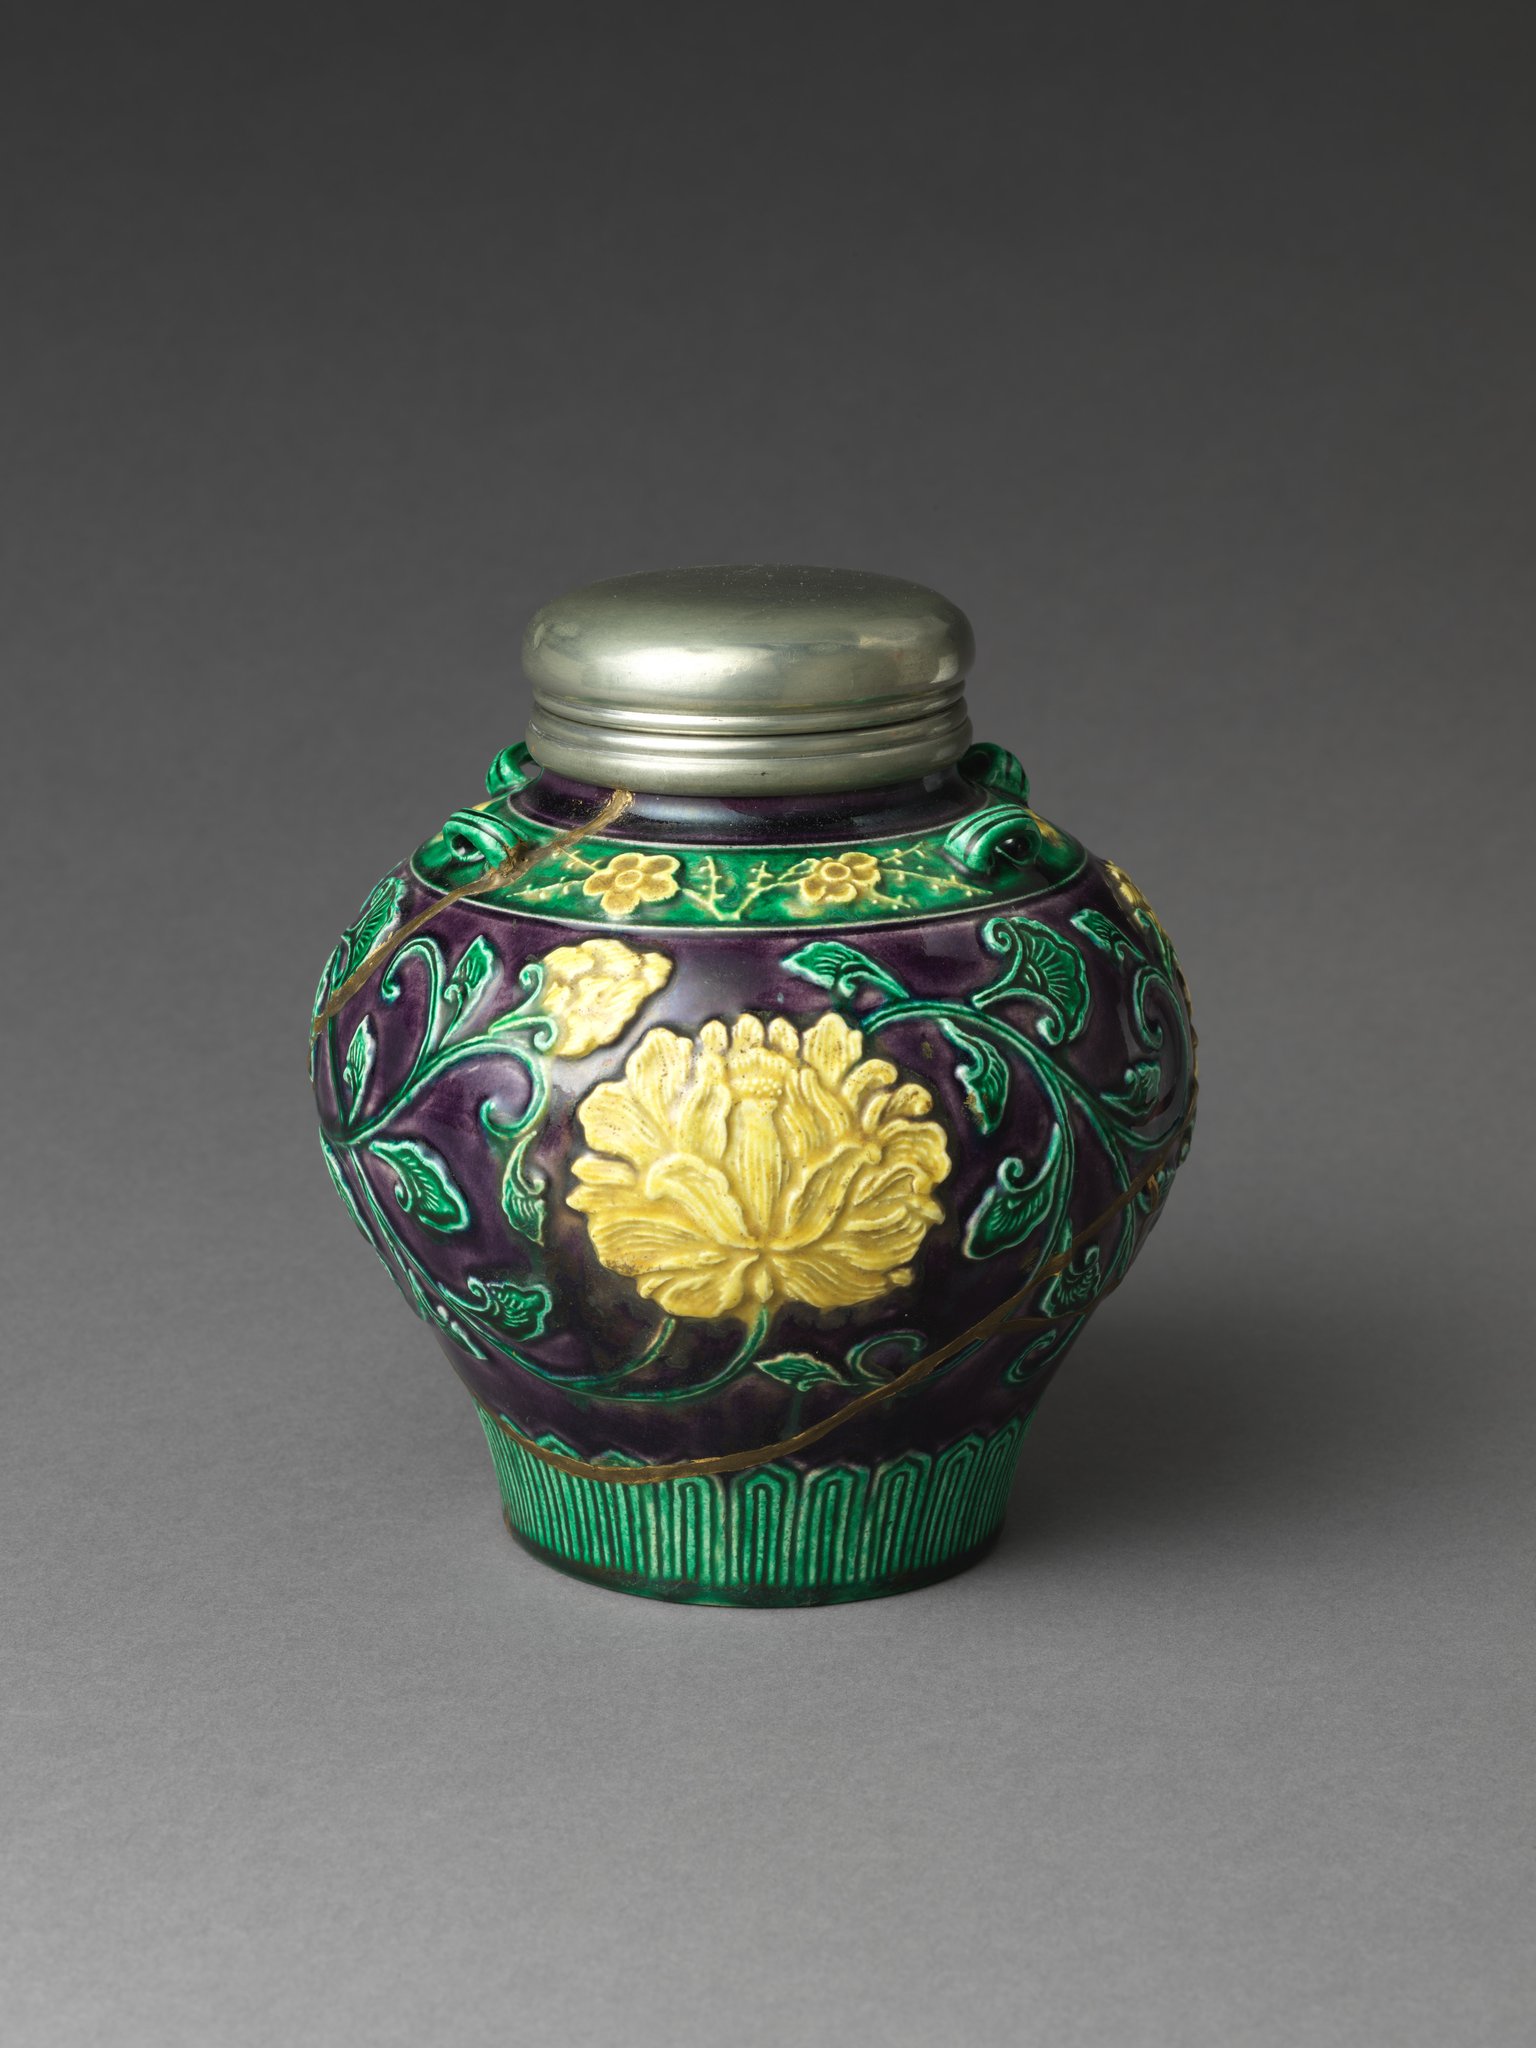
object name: tea jar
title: Sencha Tea Jar with Peony Arabesque and Plum in Cochin (Kōchi) Style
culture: japanese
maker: eiraku tokuzen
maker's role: artist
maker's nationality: japanese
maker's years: 1853-1909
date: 1867-1900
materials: glaze, gold, lacquer, pewter, stoneware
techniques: relief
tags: flowers